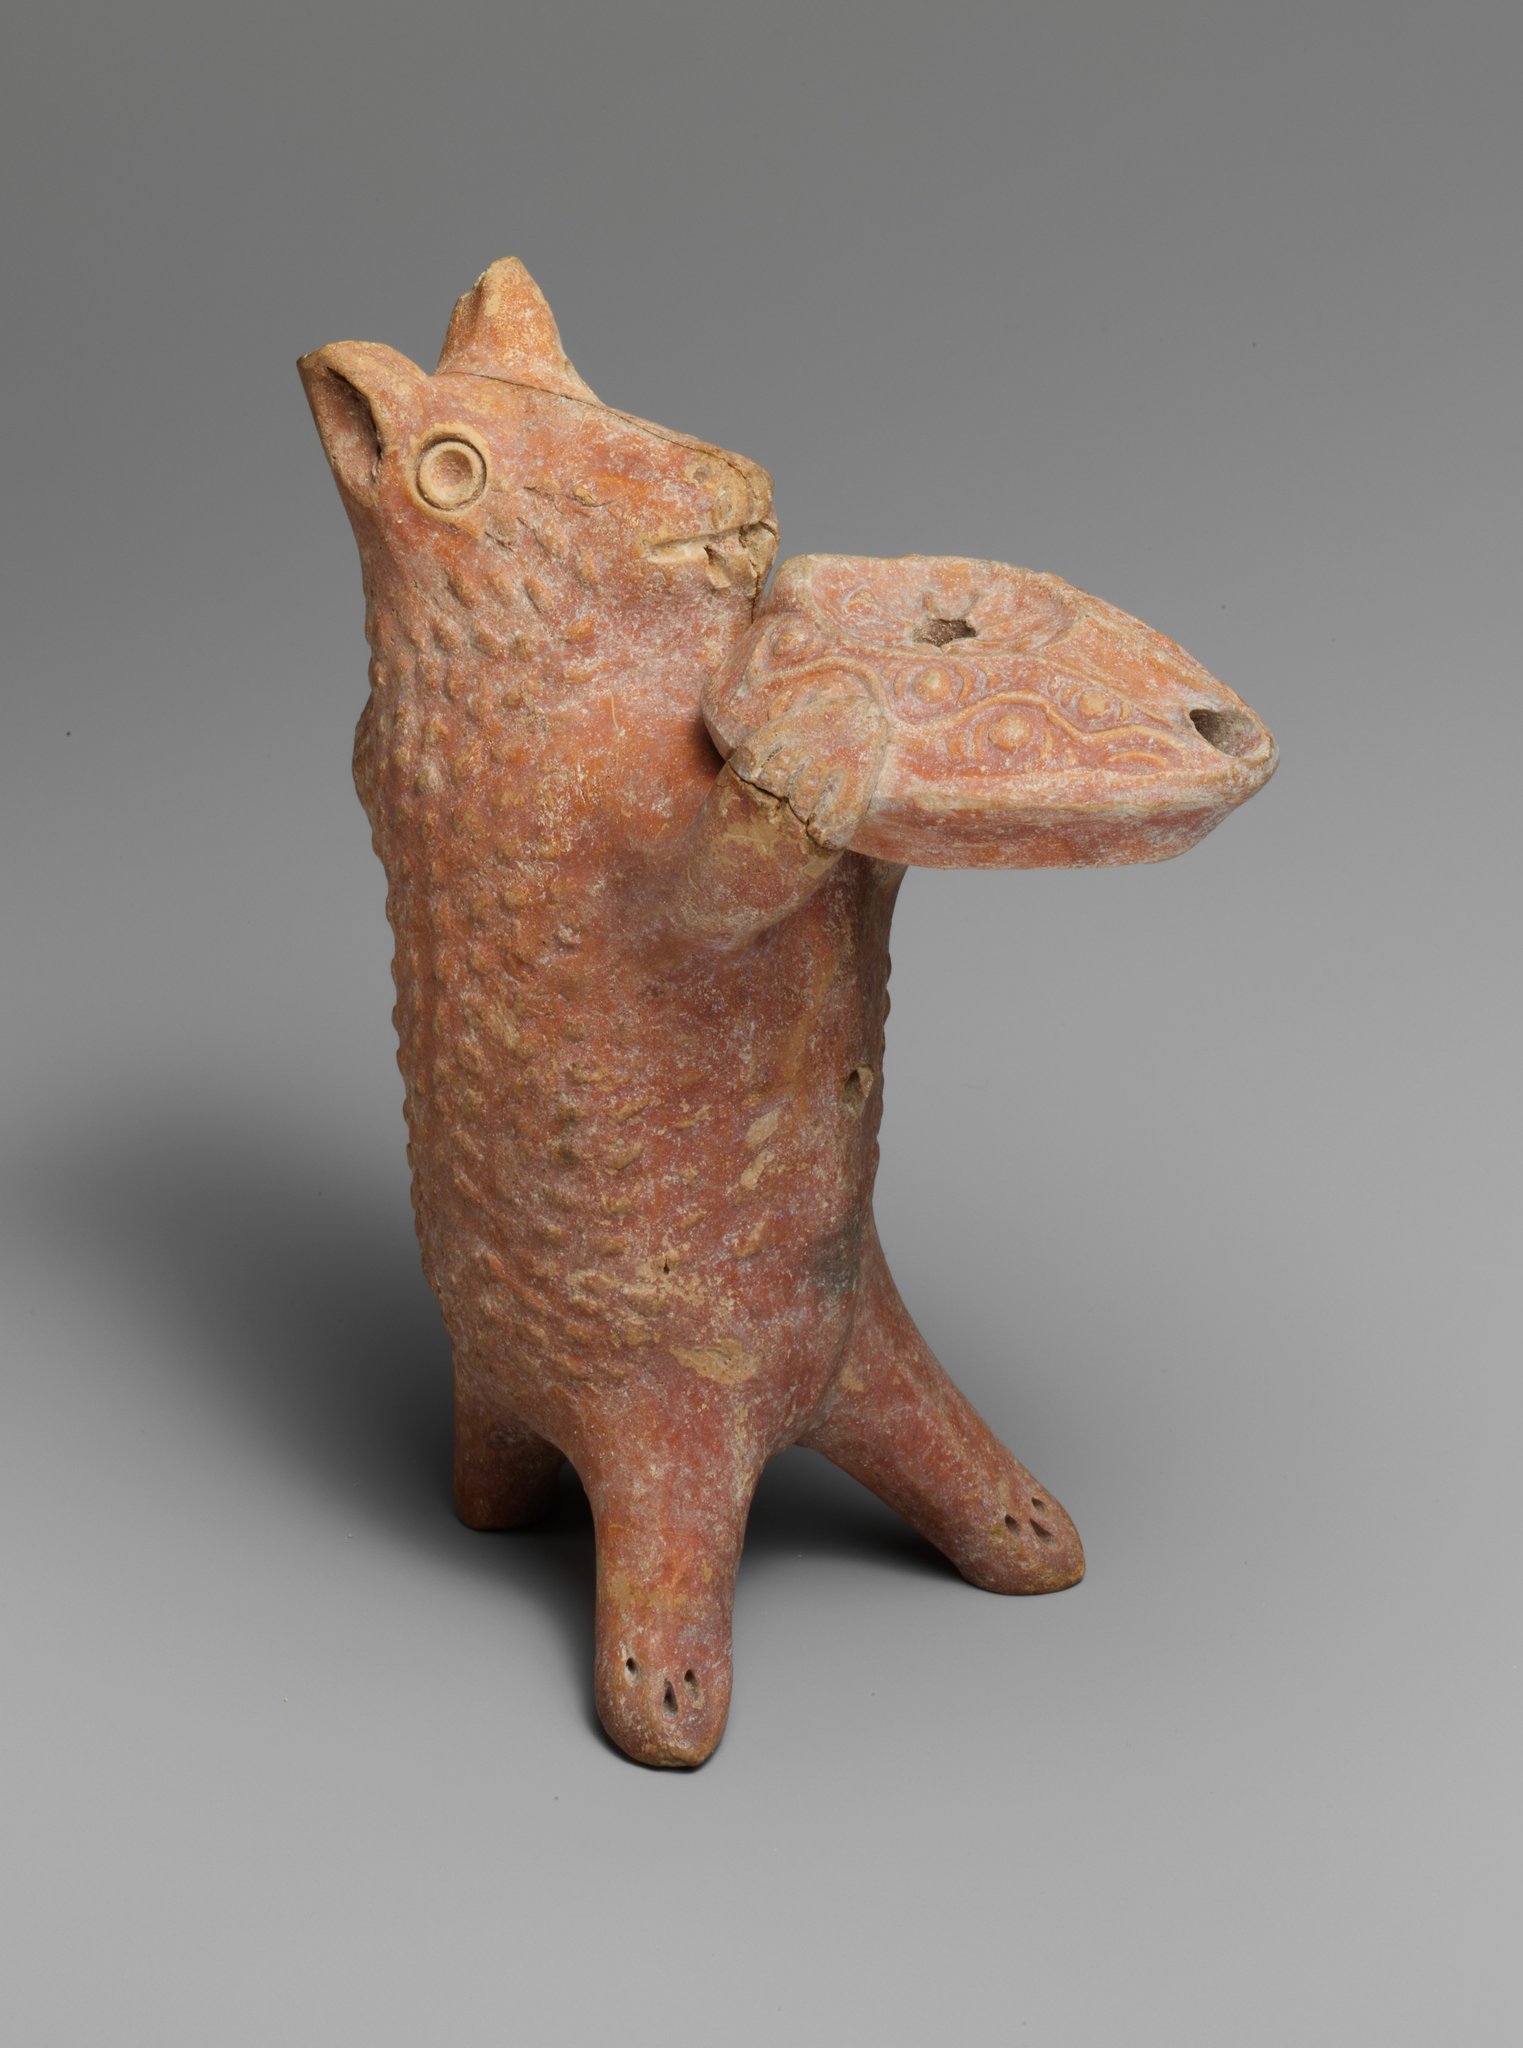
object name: statuette of a bear holding lamp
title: Terracotta statuette of a bear holding an oil lamp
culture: roman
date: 301-700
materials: terracotta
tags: bears